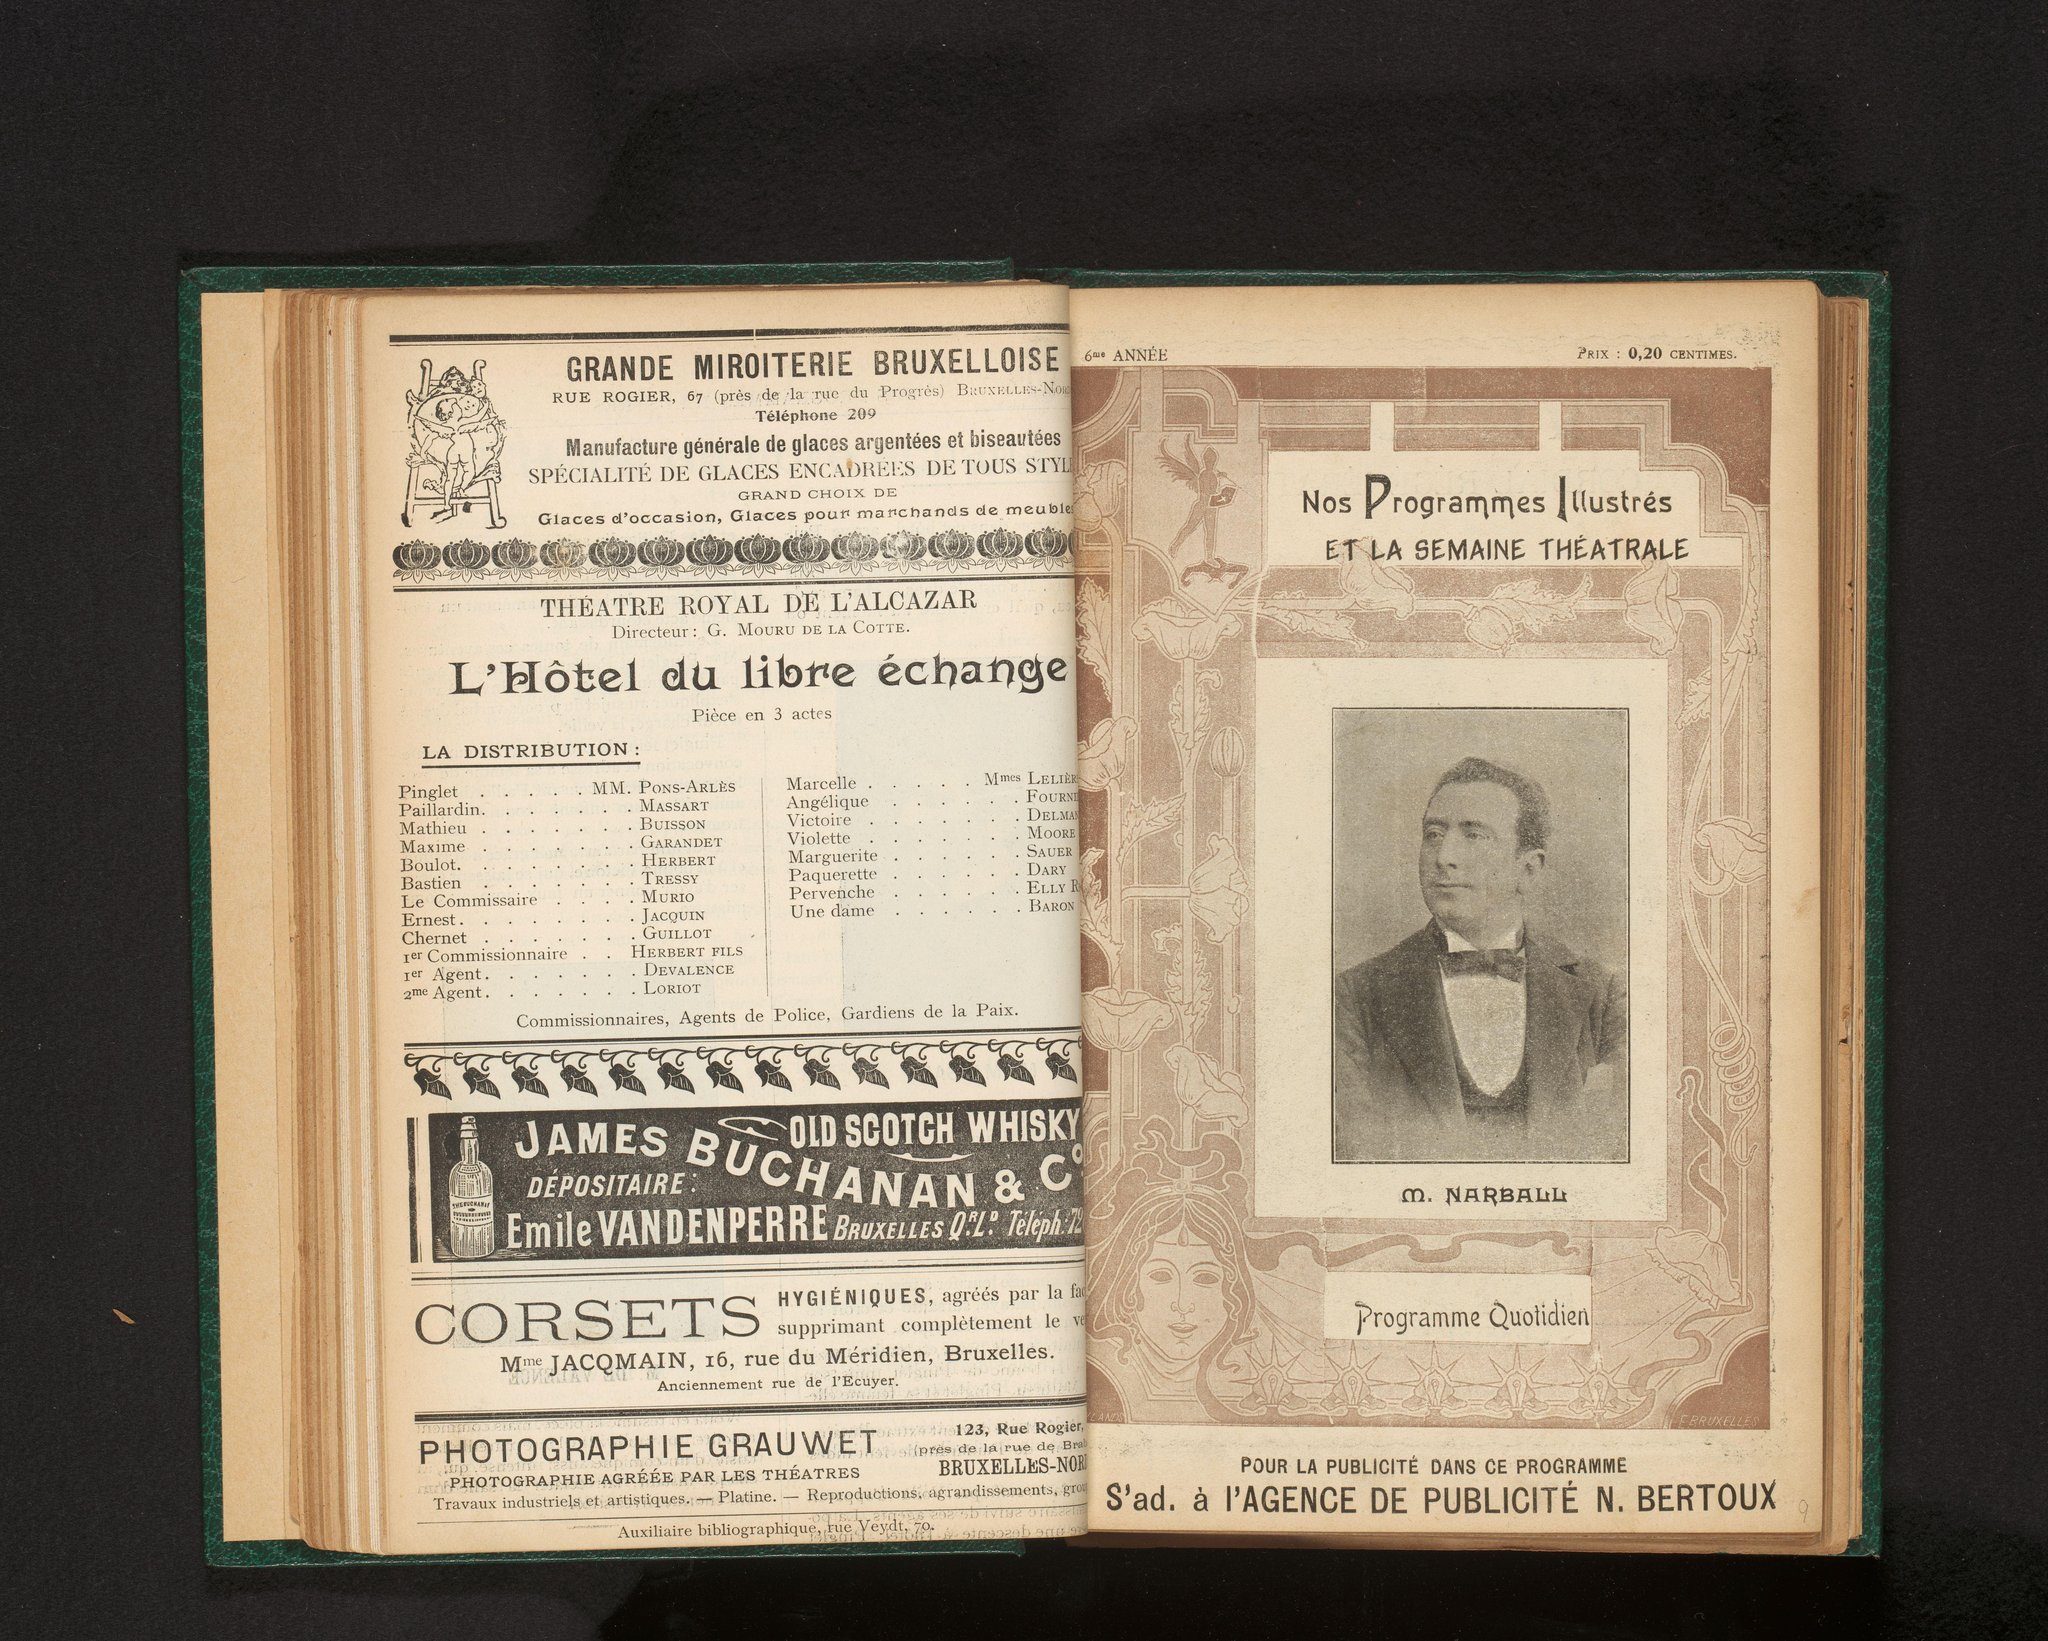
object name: page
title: M. Narball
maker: Anonymous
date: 1895-1900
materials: paper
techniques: autotype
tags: adult man, historical persons